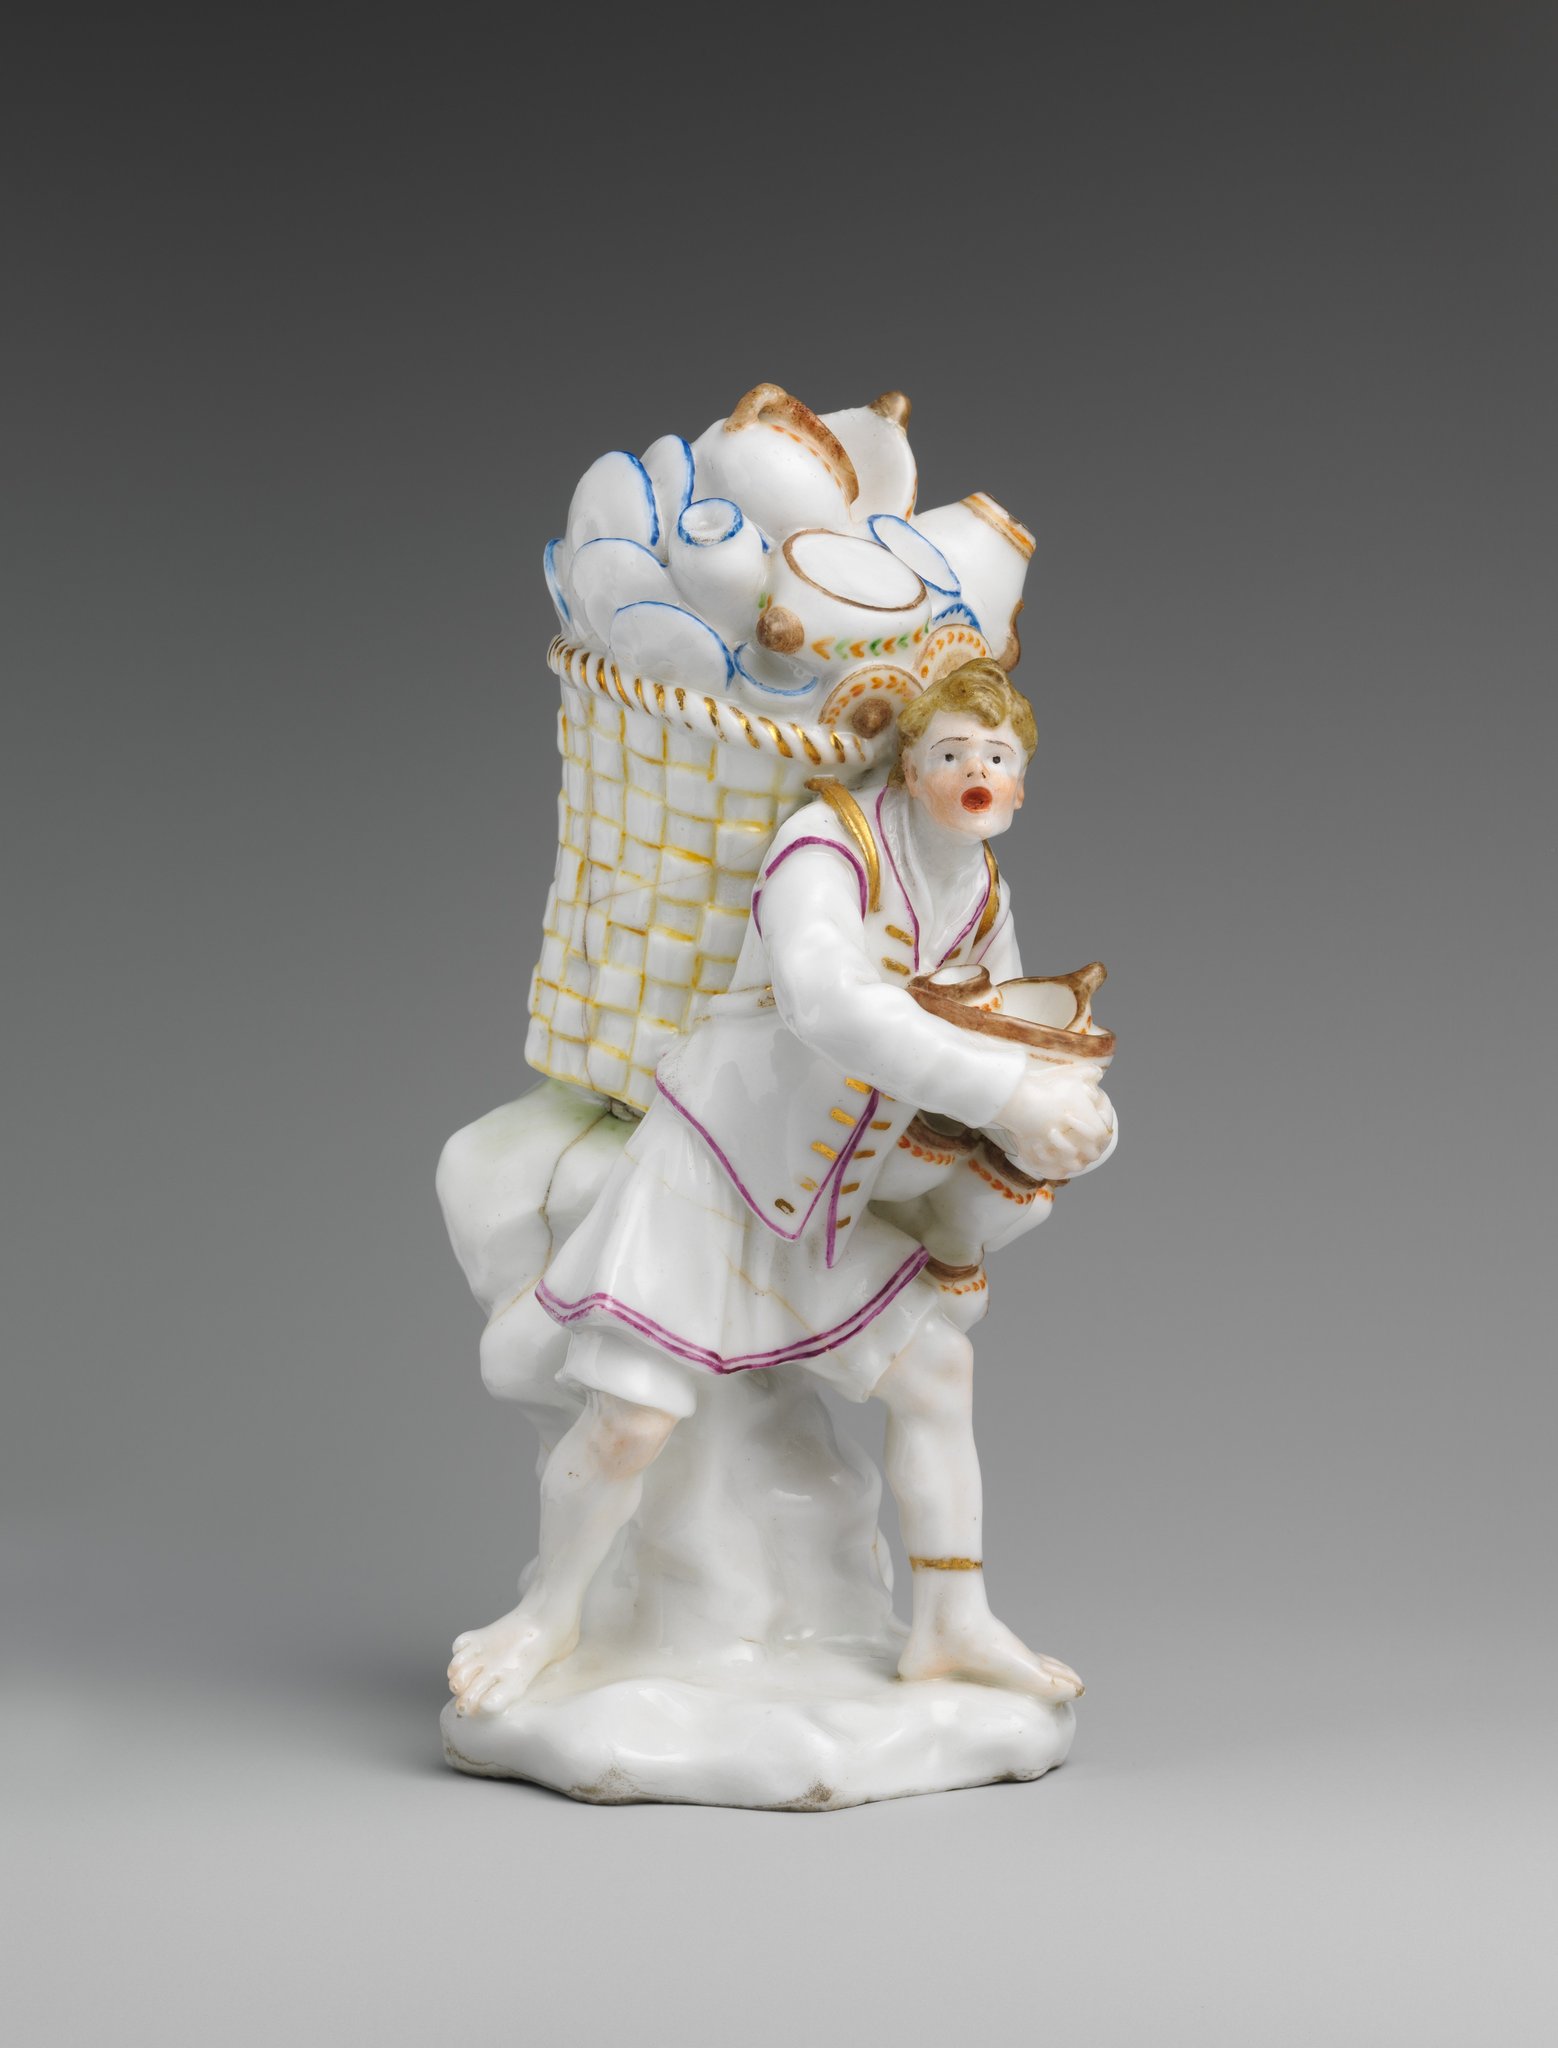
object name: figure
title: The Pottery Seller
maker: capodimonte porcelain manufactory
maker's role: manufactory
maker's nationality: italian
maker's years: 1740-1759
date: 1745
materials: enamel, gold, soft paste porcelain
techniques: polychrome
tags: men